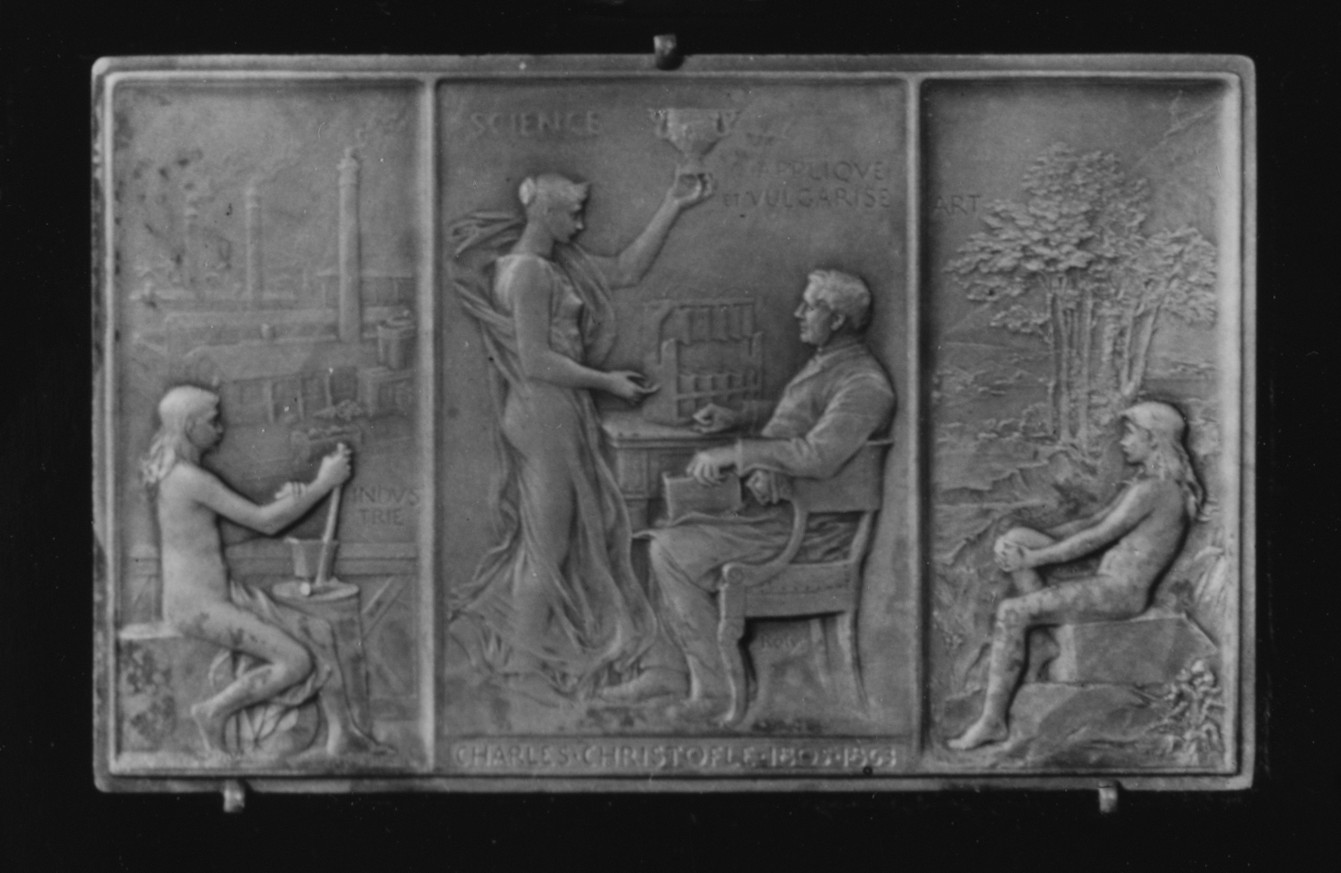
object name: plaquette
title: To Commemorate the Jubilee of the Maison Christofle, 1842–92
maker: louis-oscar roty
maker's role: artist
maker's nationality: french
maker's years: 1846-1911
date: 1893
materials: bronze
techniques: casting, silvered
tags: men,women,trees